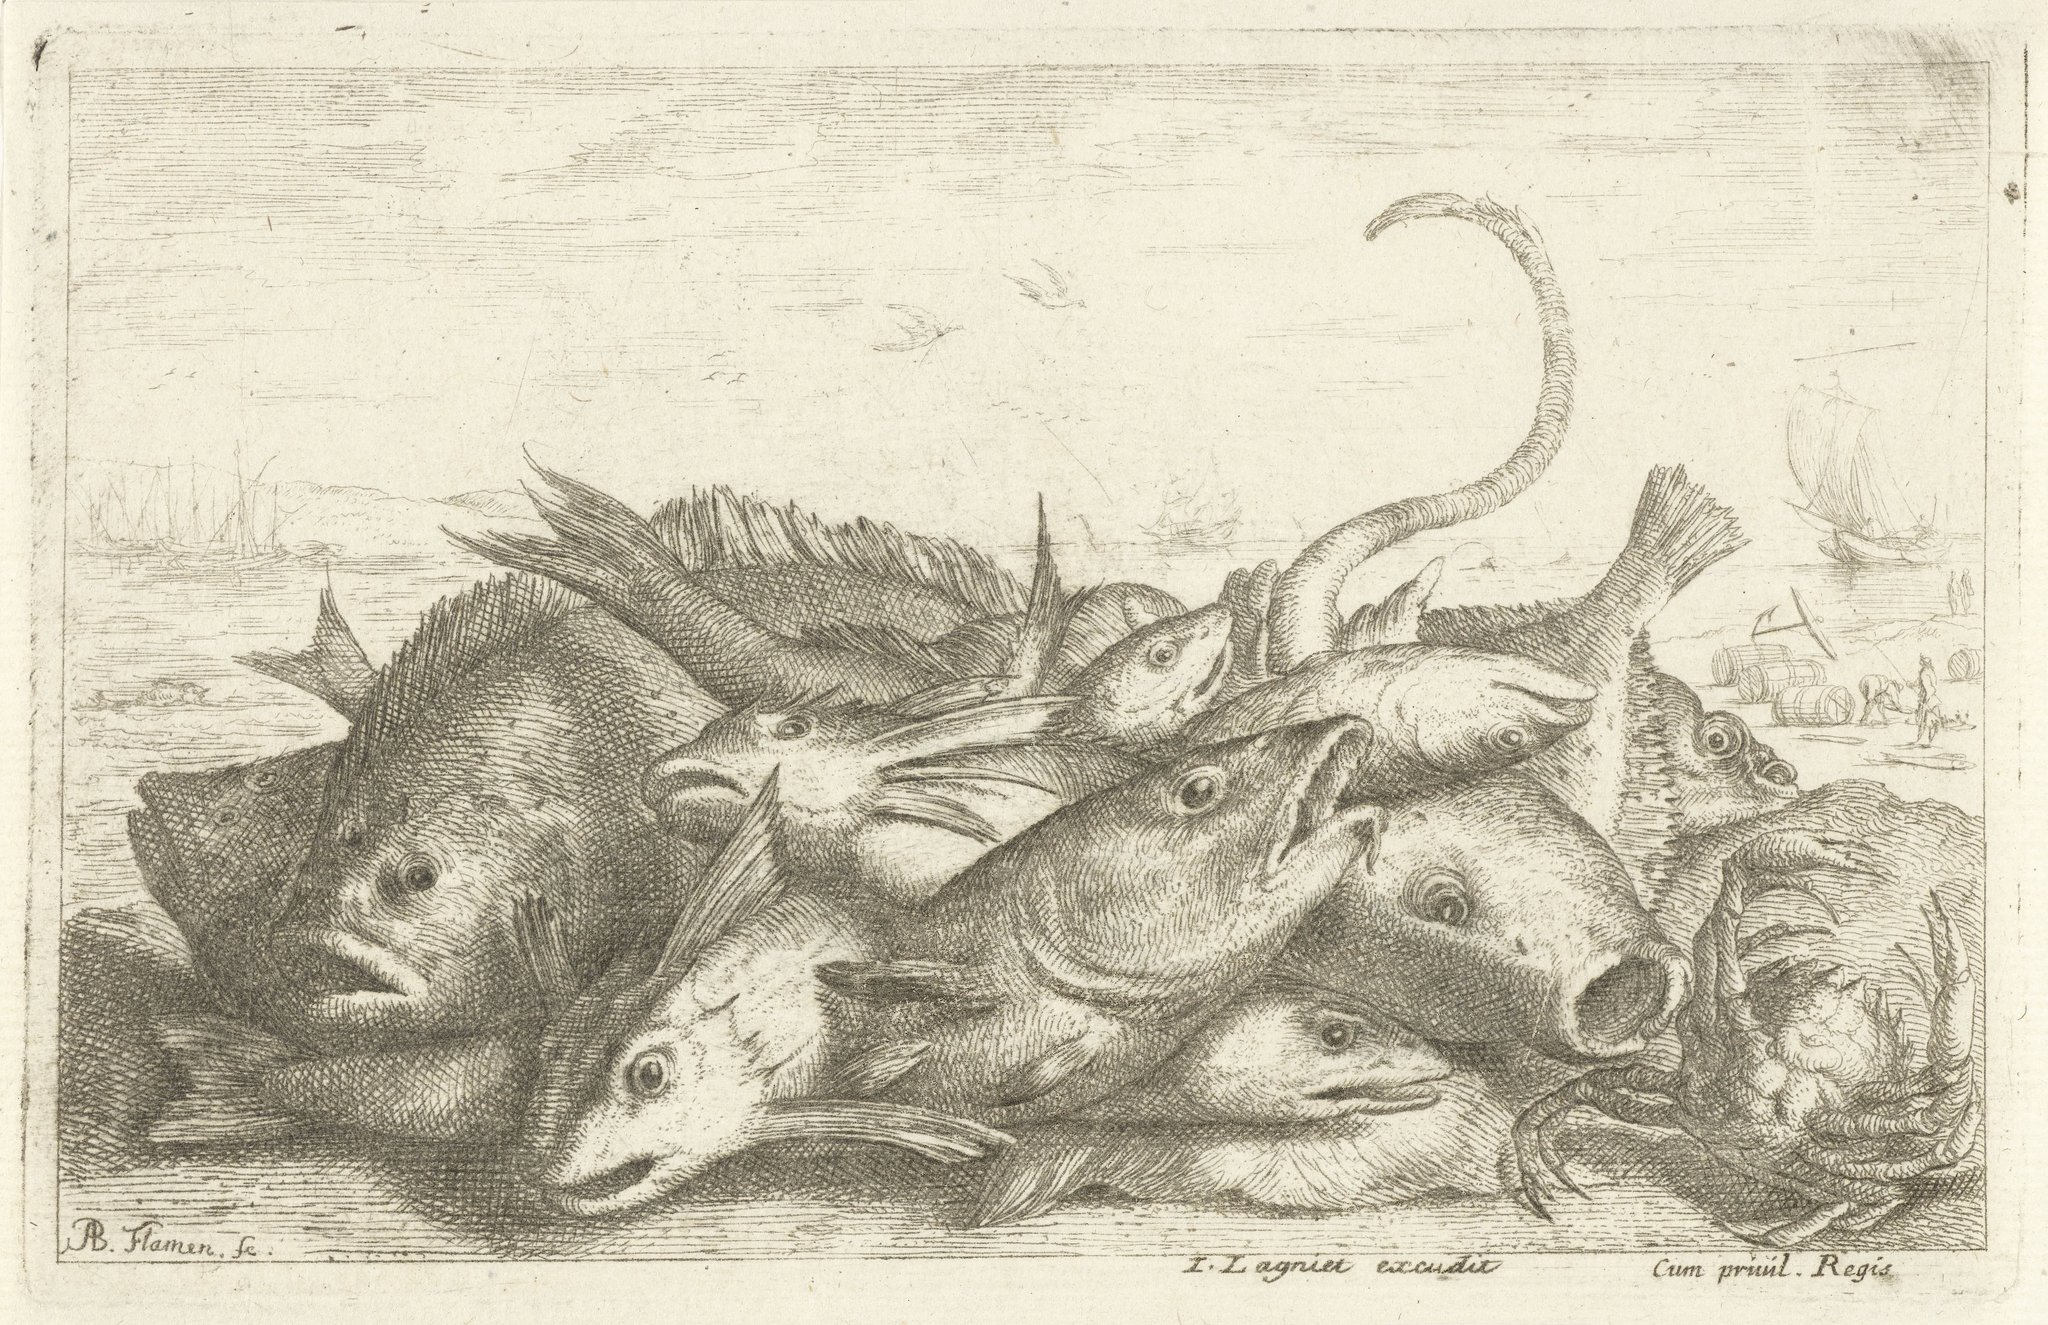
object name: print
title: Diverses Especes De Poissons tant de Mer, que d'Eeau douce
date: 1648-1670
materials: paper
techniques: etching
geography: france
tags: fishes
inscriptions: collector's mark: Lugt 2228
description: Verschillende vissen op een hoop. Op de achtergrond mensen op het strand en boten op een kalme zee.